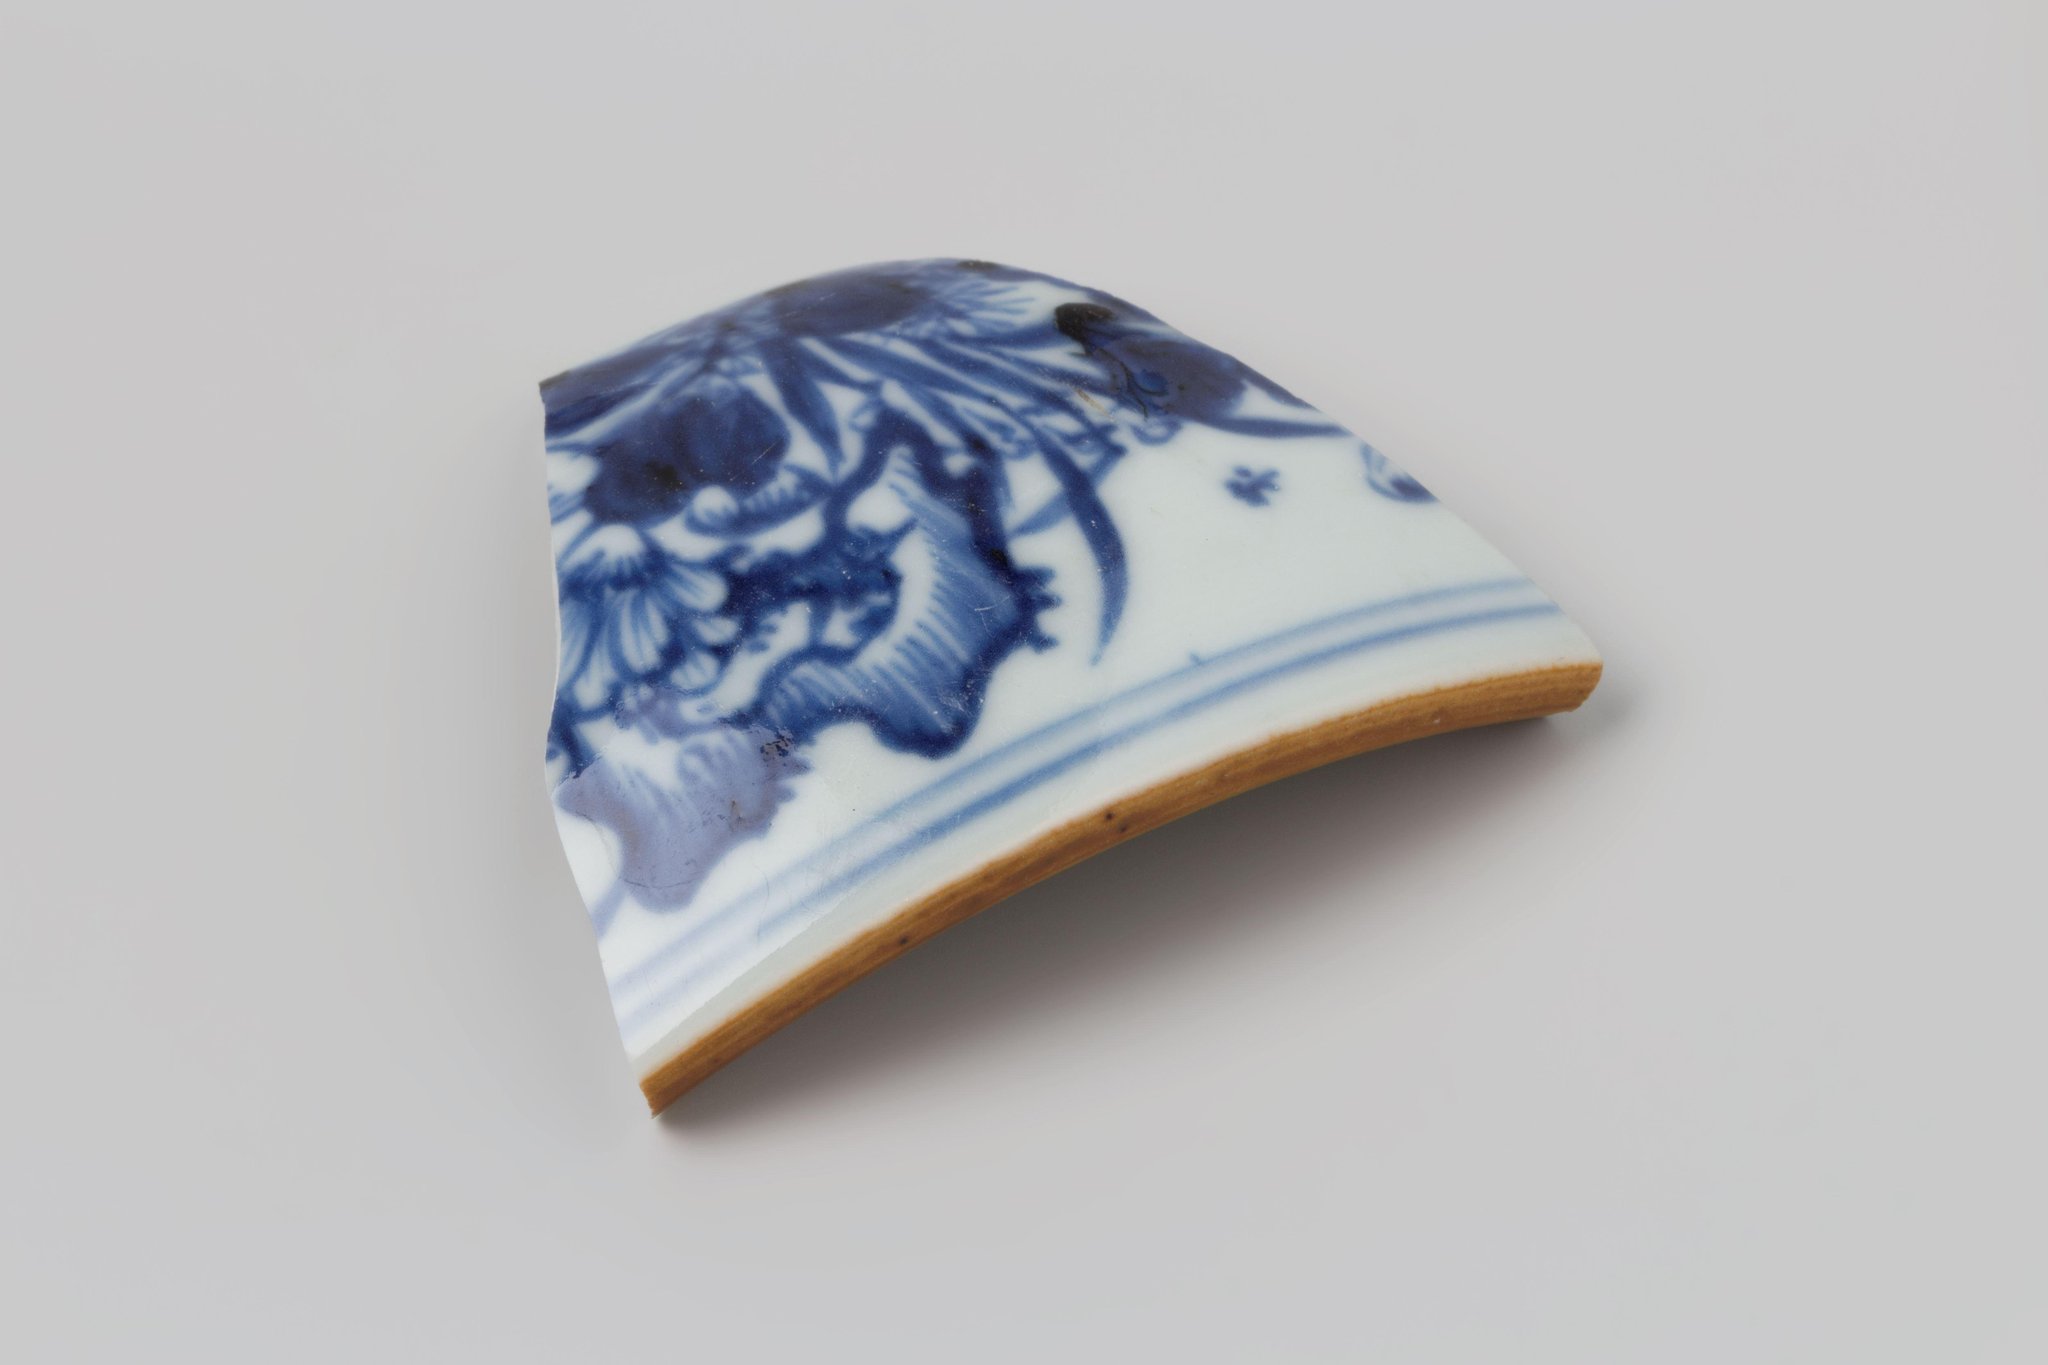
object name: bowl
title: Scherf van een kom uit het wrak van de Oost-Indiëvaarder 't Vliegend Hart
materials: porcelain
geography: netherlands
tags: 't vliegend hart (schip), verenigde oostindische compagnie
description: Eén scherf uit de rand van een porseleinen kom. Delftsblauw met de tekening van buiten. Bowl.